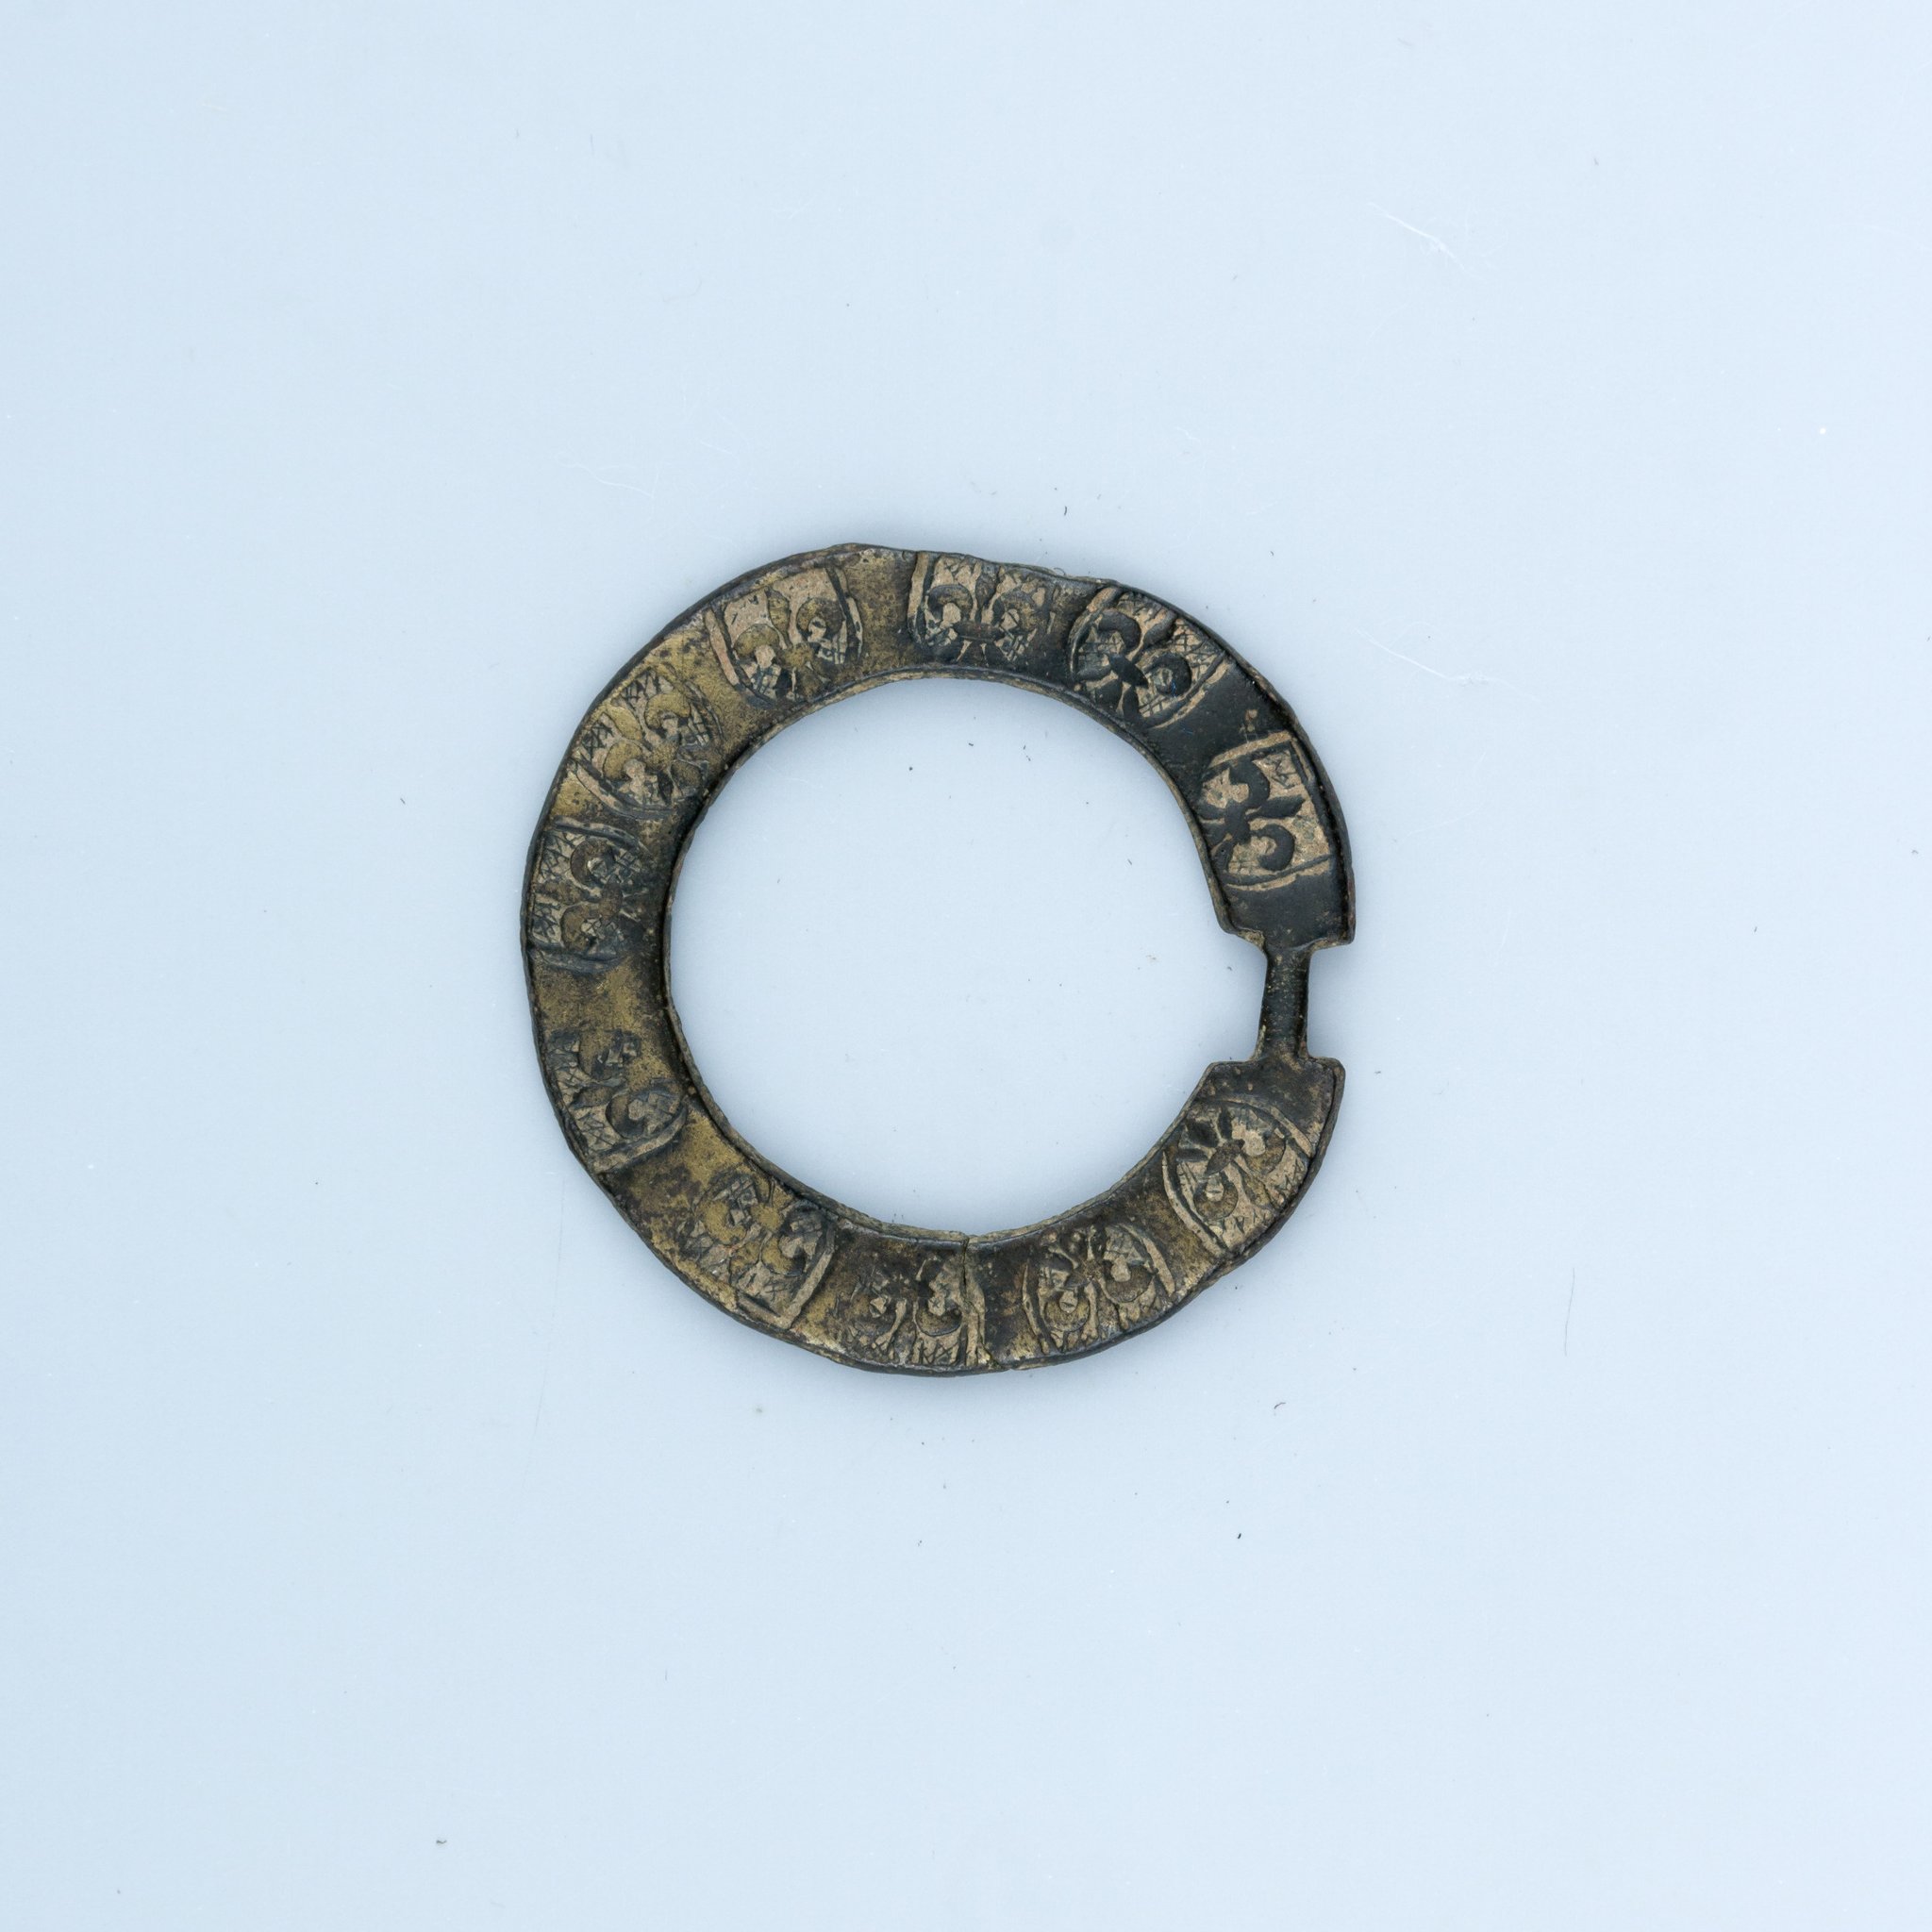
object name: buckle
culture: european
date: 1401-1700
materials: brass